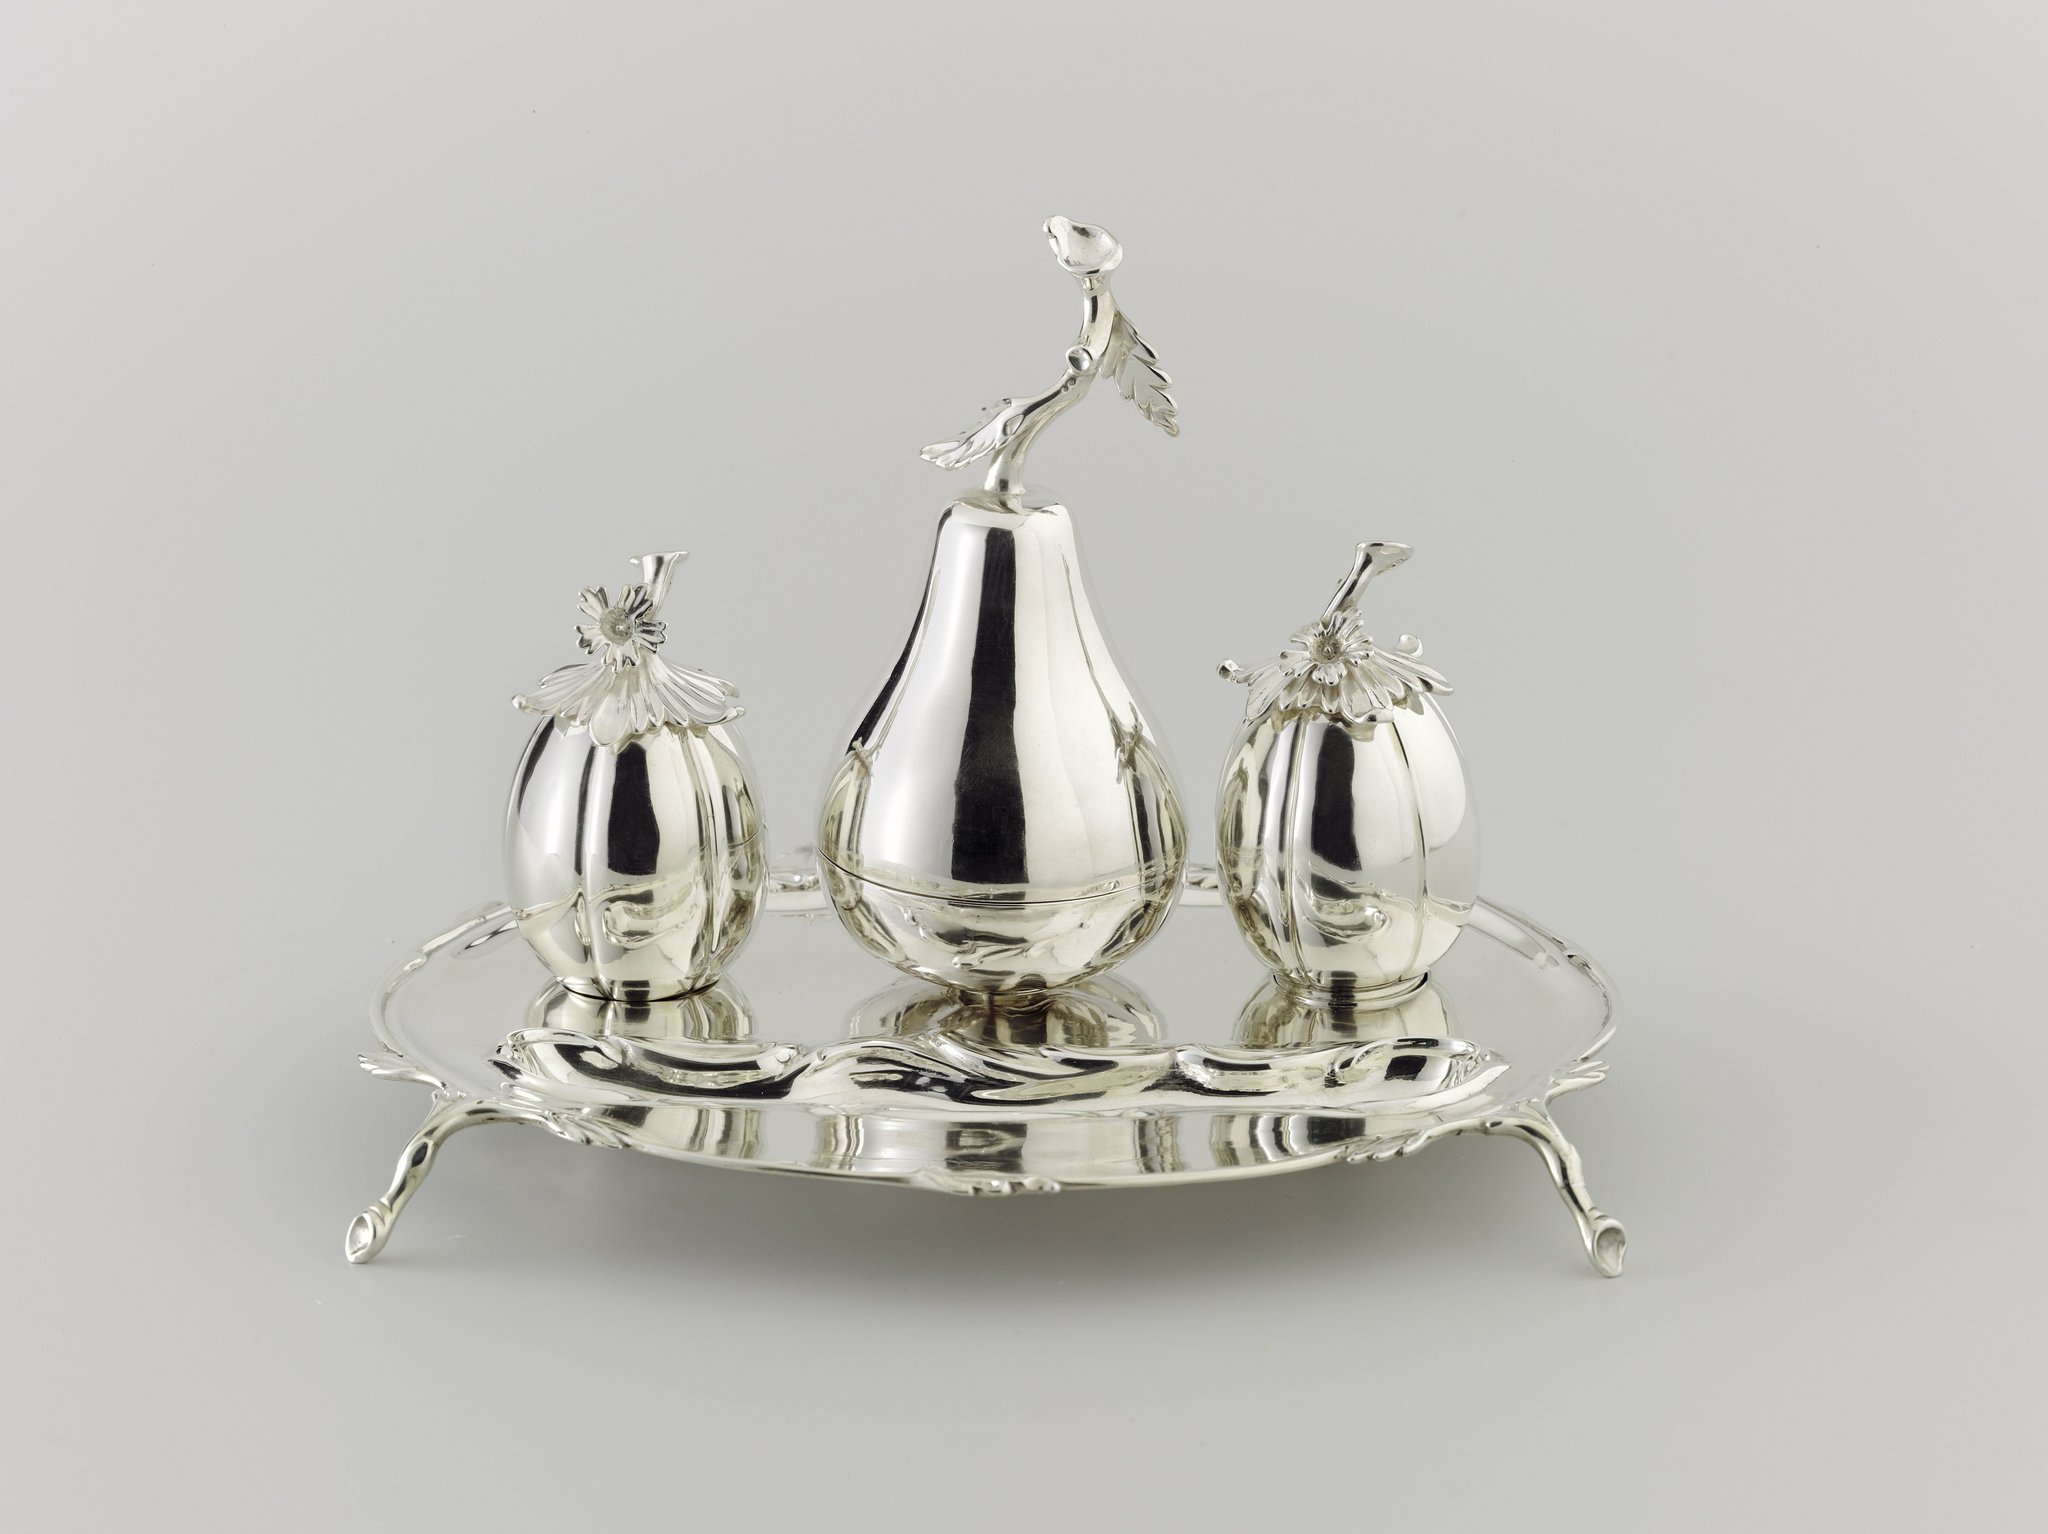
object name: inkstand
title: Inktstel van zilver. Blad met uitgebogen voorzijde; inktpot en zandstrooier meloenvormig, tafelbel peervormig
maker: laurens potmans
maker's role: goud- en zilversmid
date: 1773-1782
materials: silver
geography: middelburg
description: Inkstand Silver Middelburg, c. 1775, by Laurens Potmans Given by the Commissie voor Fotoverkoop, 1970